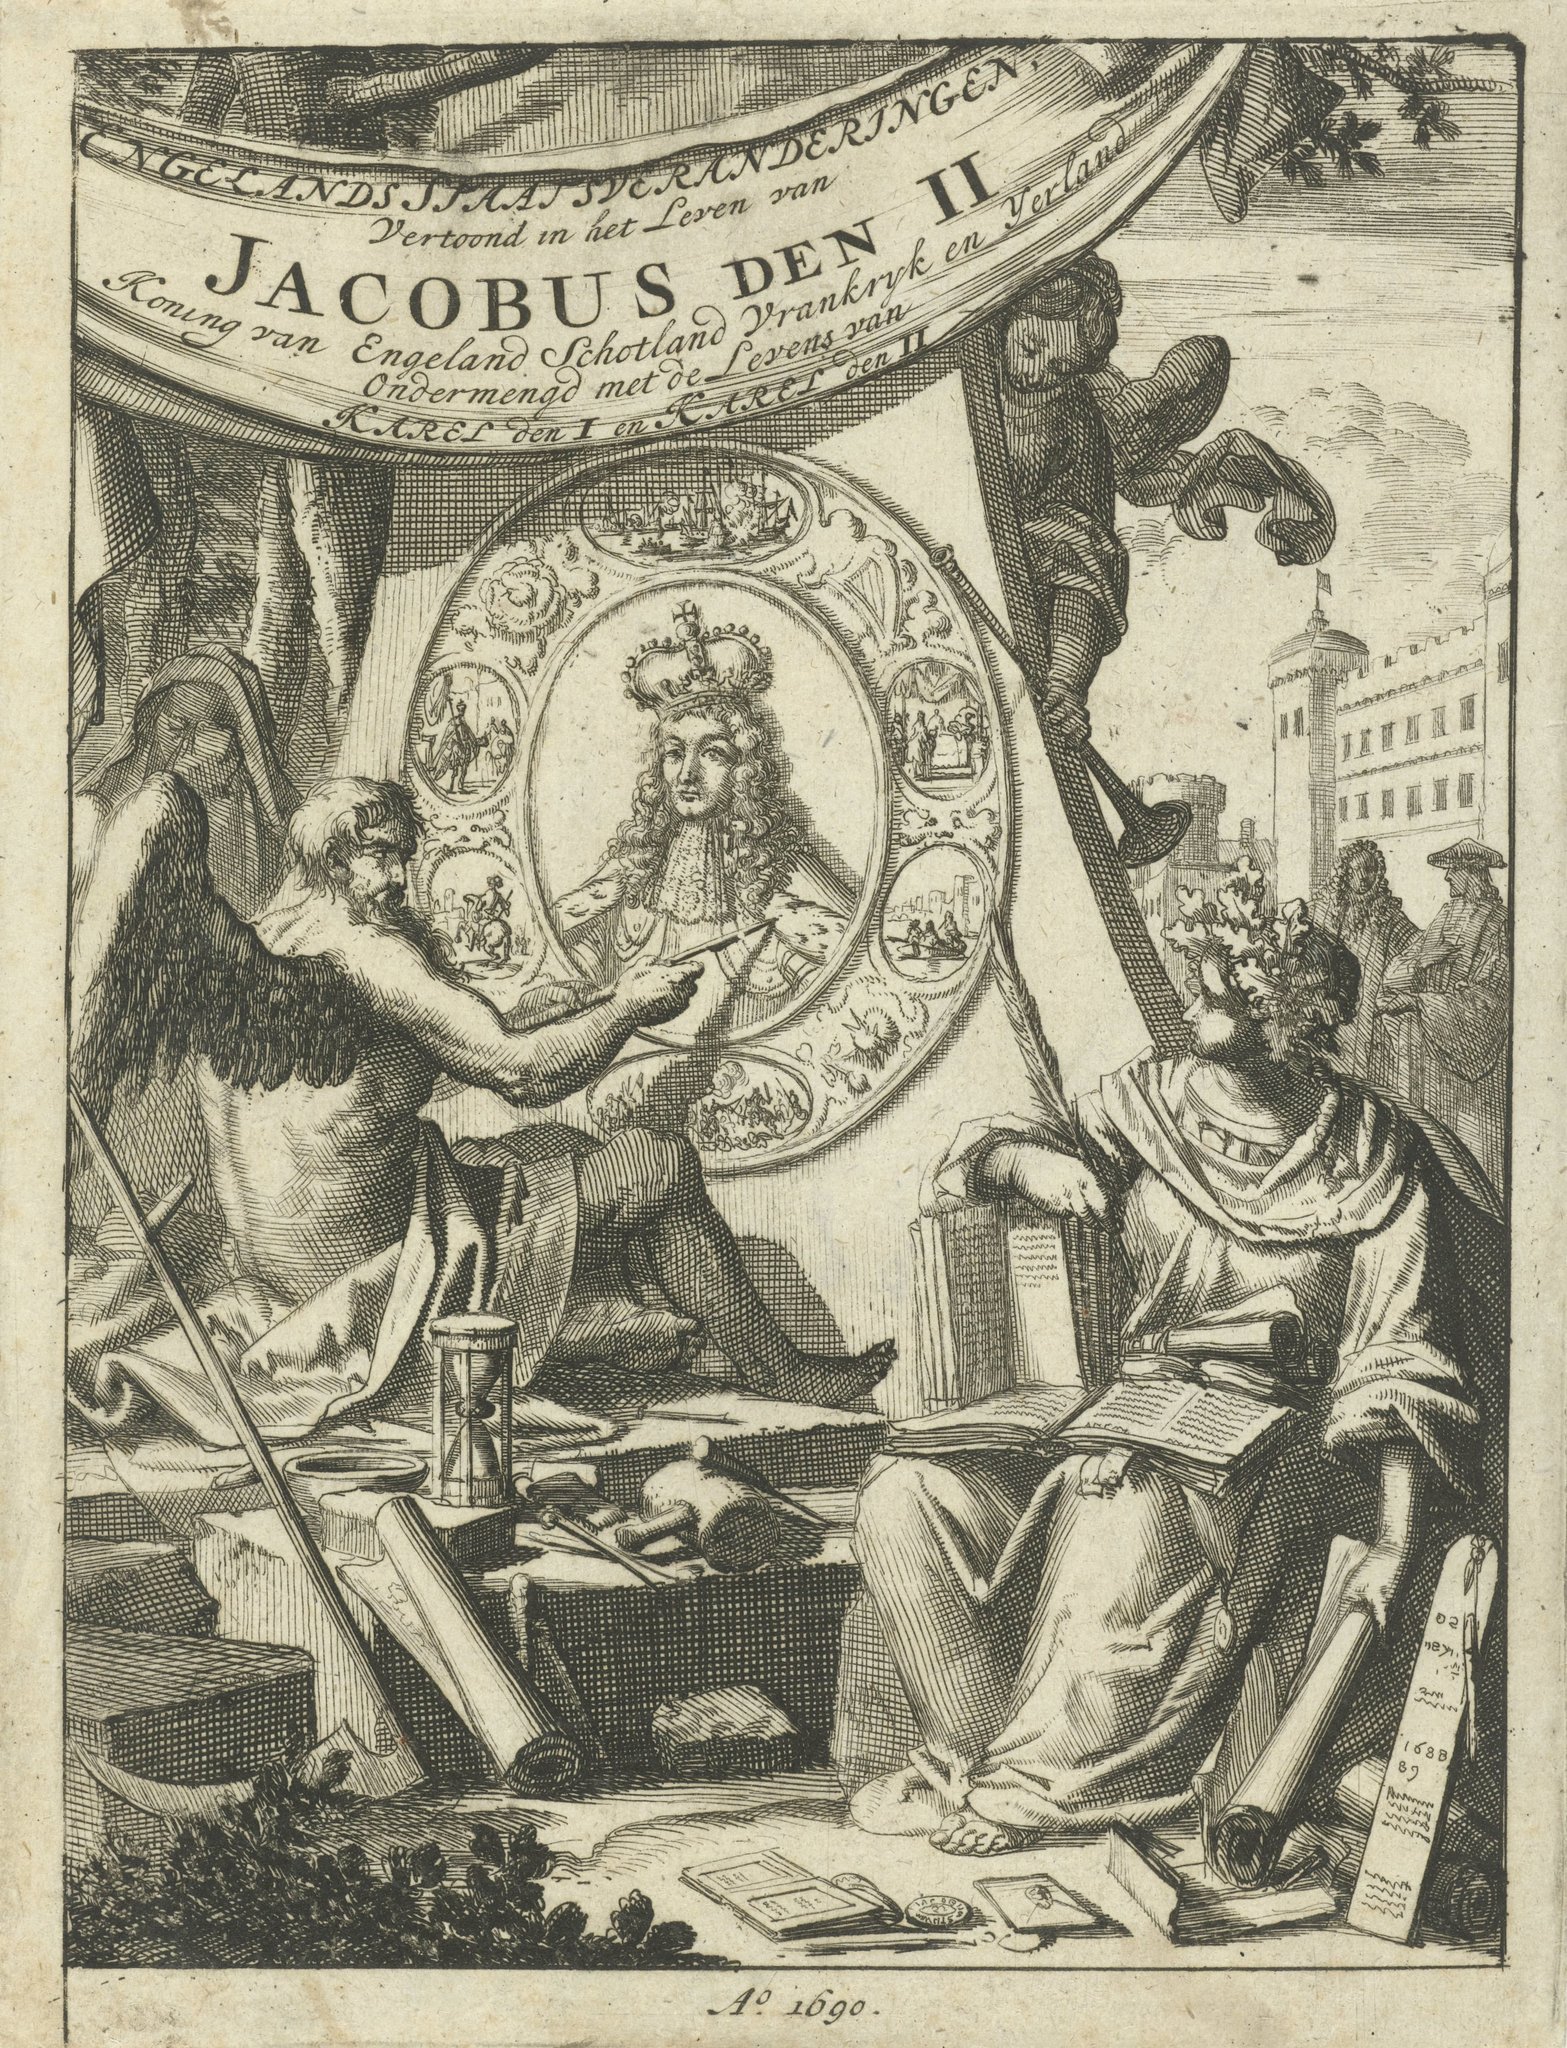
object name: print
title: Portret van koning Jacobus II, bestudeerd door Vader Tijd en Geschiedenis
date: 1690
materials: paper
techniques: etching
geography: amsterdam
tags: jacobus ii (koning van engeland en schotland), obelisk, needle, 'historia'; 'historia' (ripa), fame; 'fama', 'fama buona', 'fama chiara' (ripa), father time, man with wings and scythe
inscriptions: collector's mark: Lugt 2228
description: Titelpagina voor: Hoogstraten, David van. Engelands staatsveranderingen, vertoond in het leven van Jacobus den II. Haarlem: Jacob Albertsz van Beverwijk, Amsterdam: Timotheus ten Hoorn, 1690.